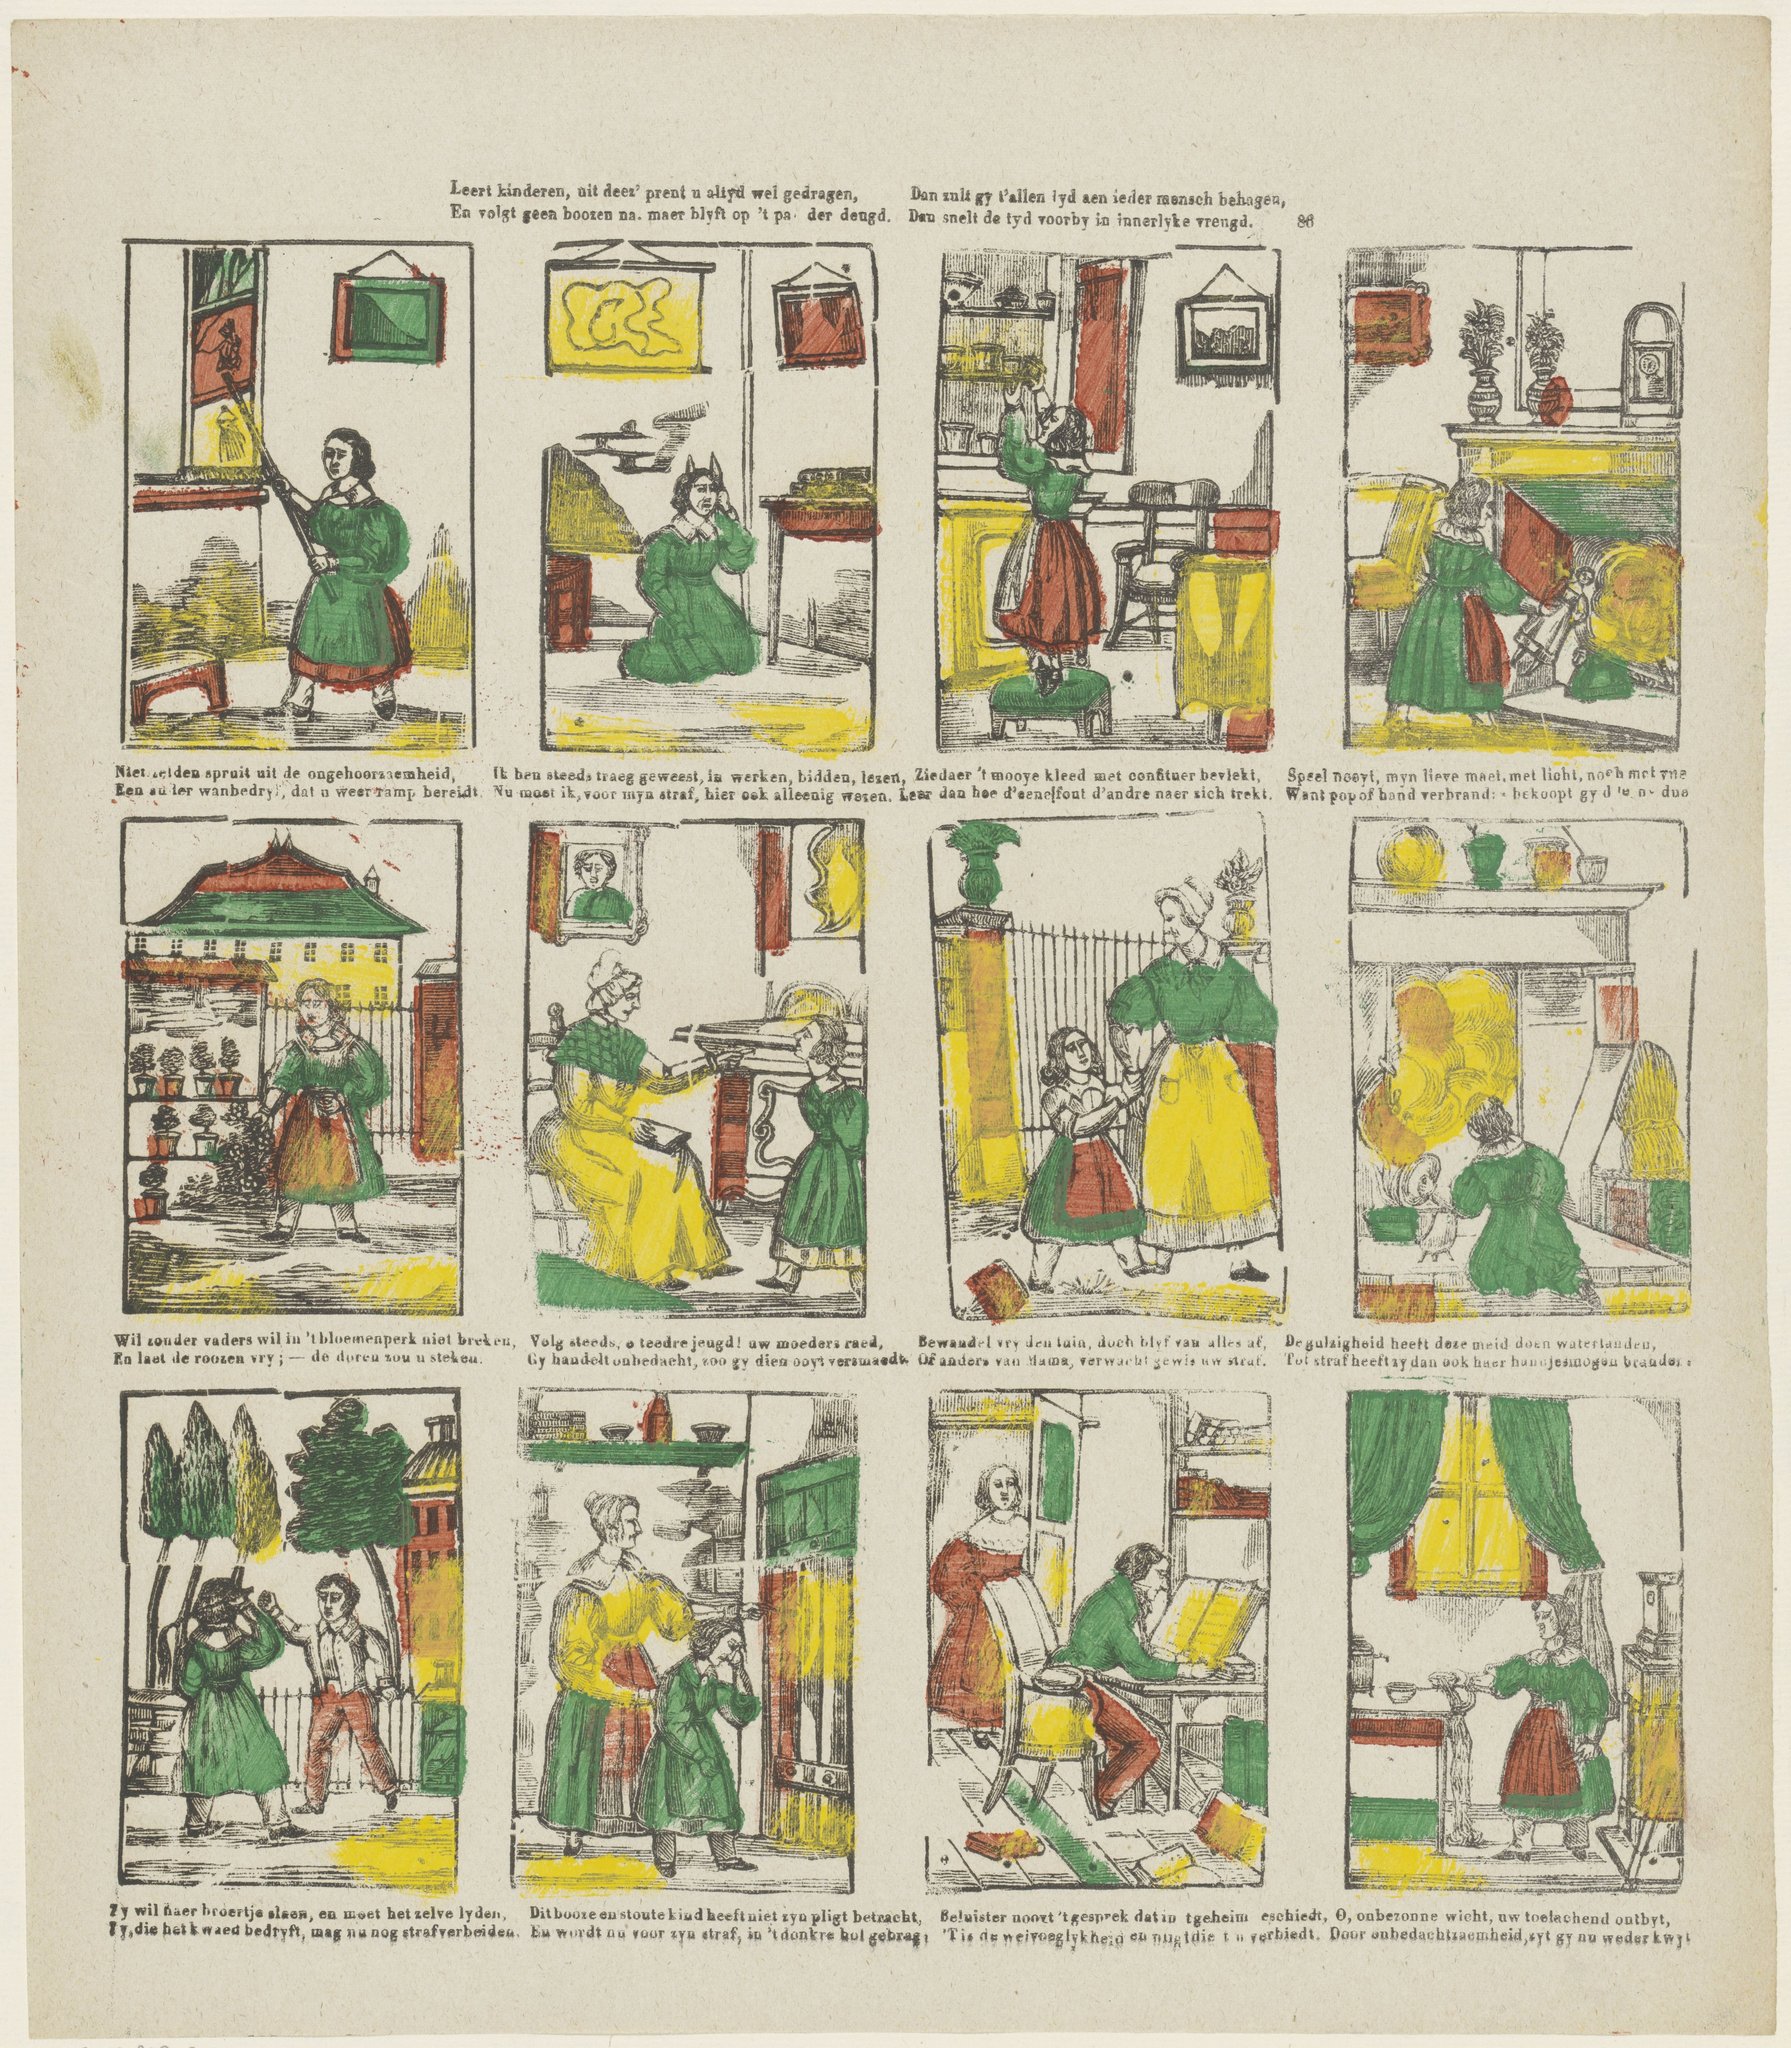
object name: print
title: Leert kinderen, uit deez' prent u altyd wel gedragen, / En volgt geen boozen na, maer blyft op 't pad der deugd. / Dan zult gy 't allen tyd aen ieder mensch behagen, / Dan snelt de tyd voorby in innerlyke vreugd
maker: Anonymous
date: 1833-1900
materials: paper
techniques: colour, letterpress printing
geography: netherlands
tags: correction of naughty children, bad behaviour, good behaviour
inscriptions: collector's mark: Lugt 2760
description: Blad met 12 moraliserende taferelen met deugdzame en ondeugdzame kinderen. Onder elke afbeelding een vers. Genummerd rechtsboven: 86.